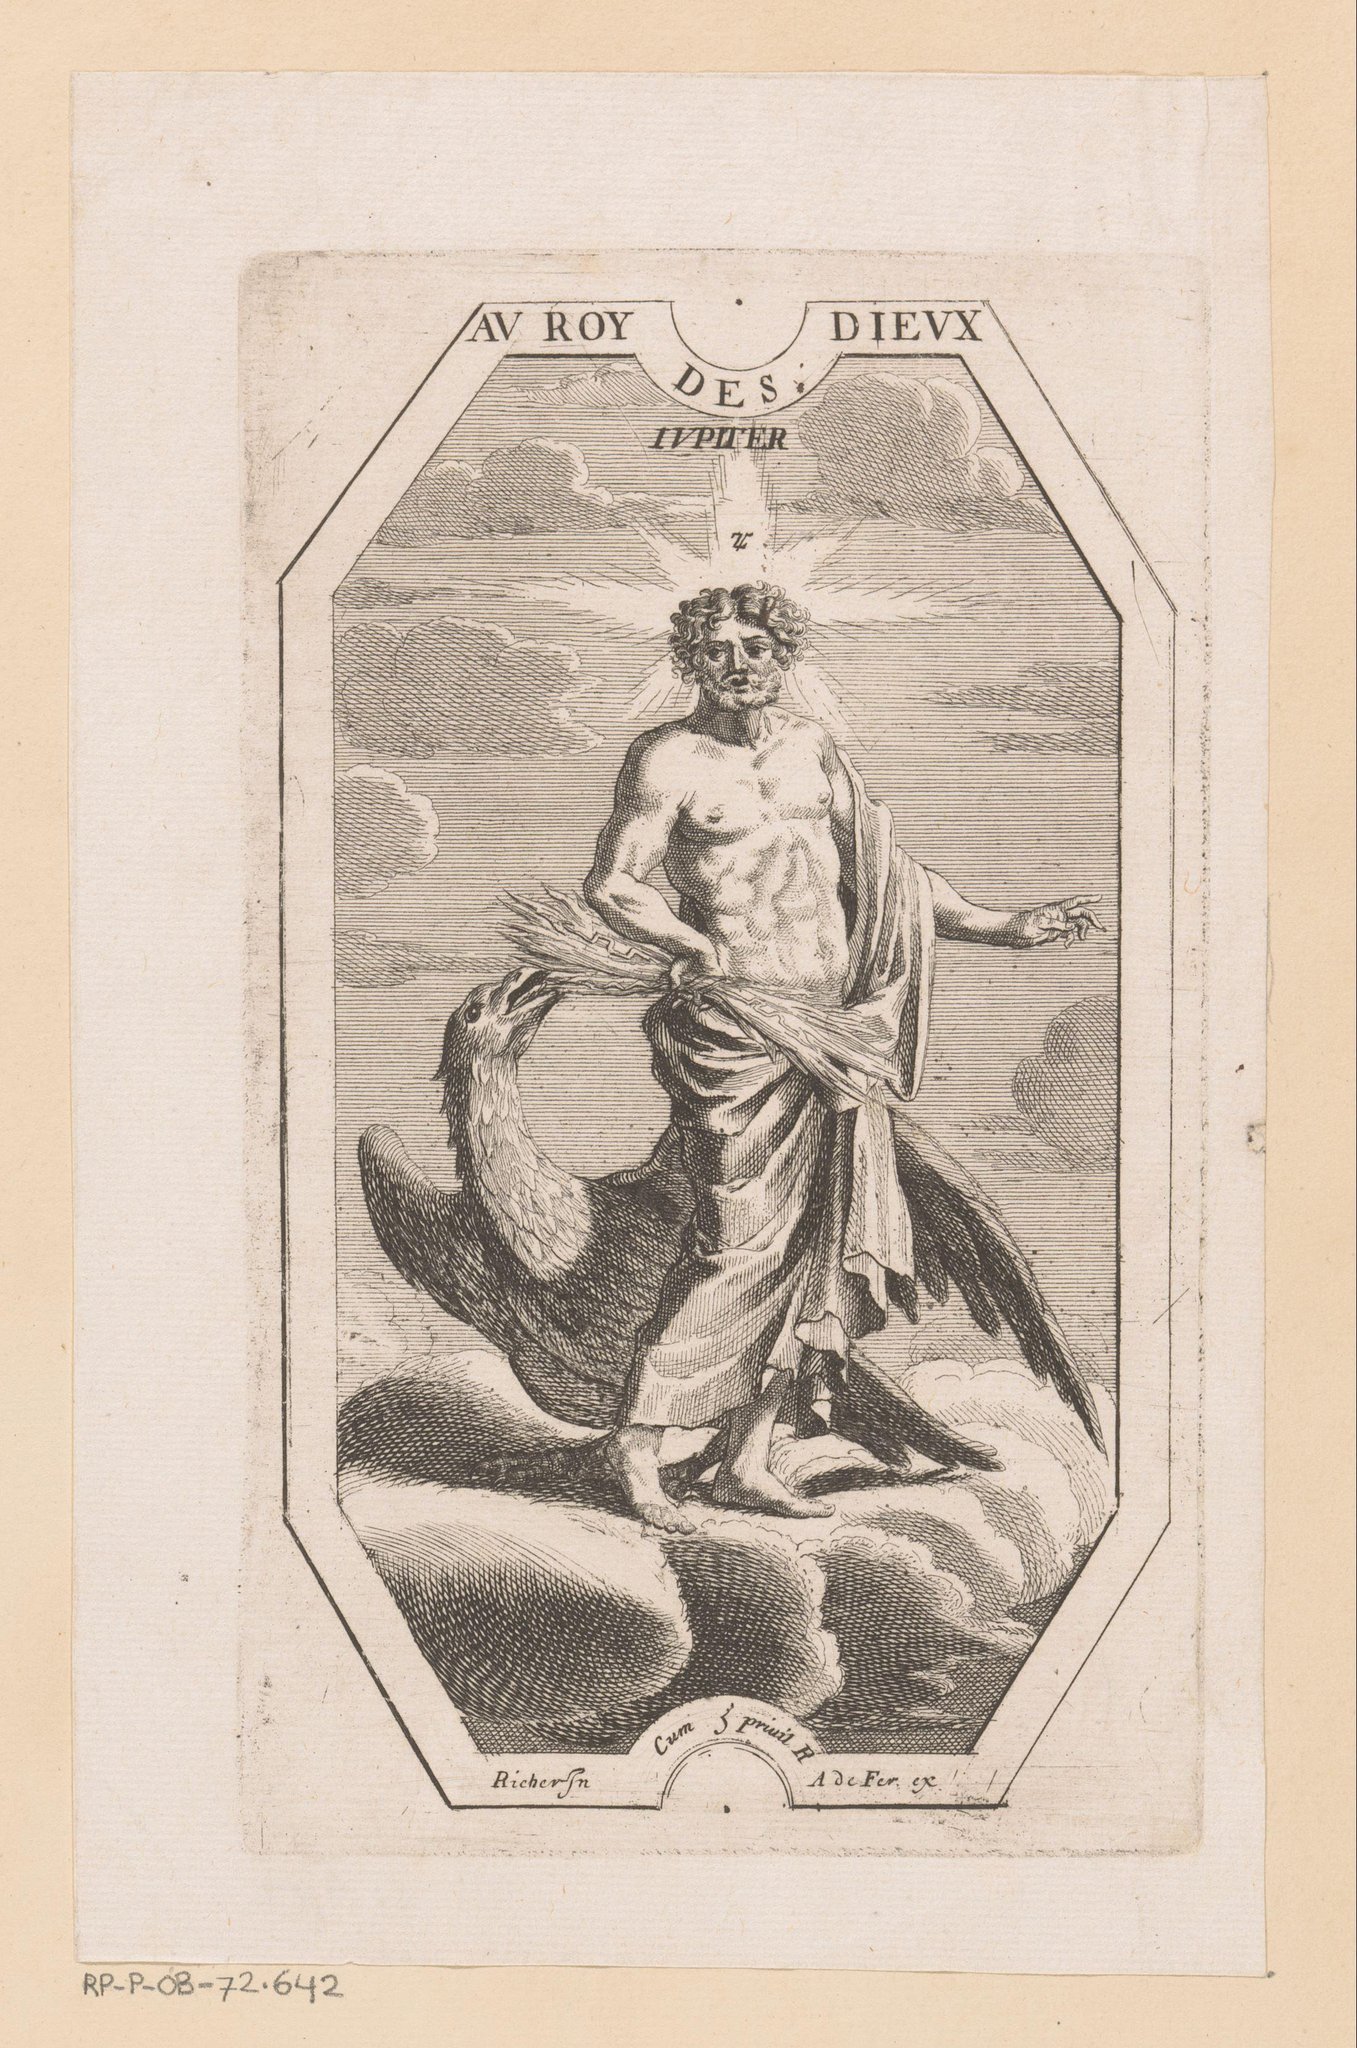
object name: print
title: Jupiter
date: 1630-1673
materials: paper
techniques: engraving, etching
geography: france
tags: (story of) jupiter (zeus), jupiter (planet)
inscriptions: collector's mark: Lugt 240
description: Prent maakt deel uit van een serie met in ieder geval zeven genummerde prenten (collectie Rijksmuseum). Dit is nummer 5.